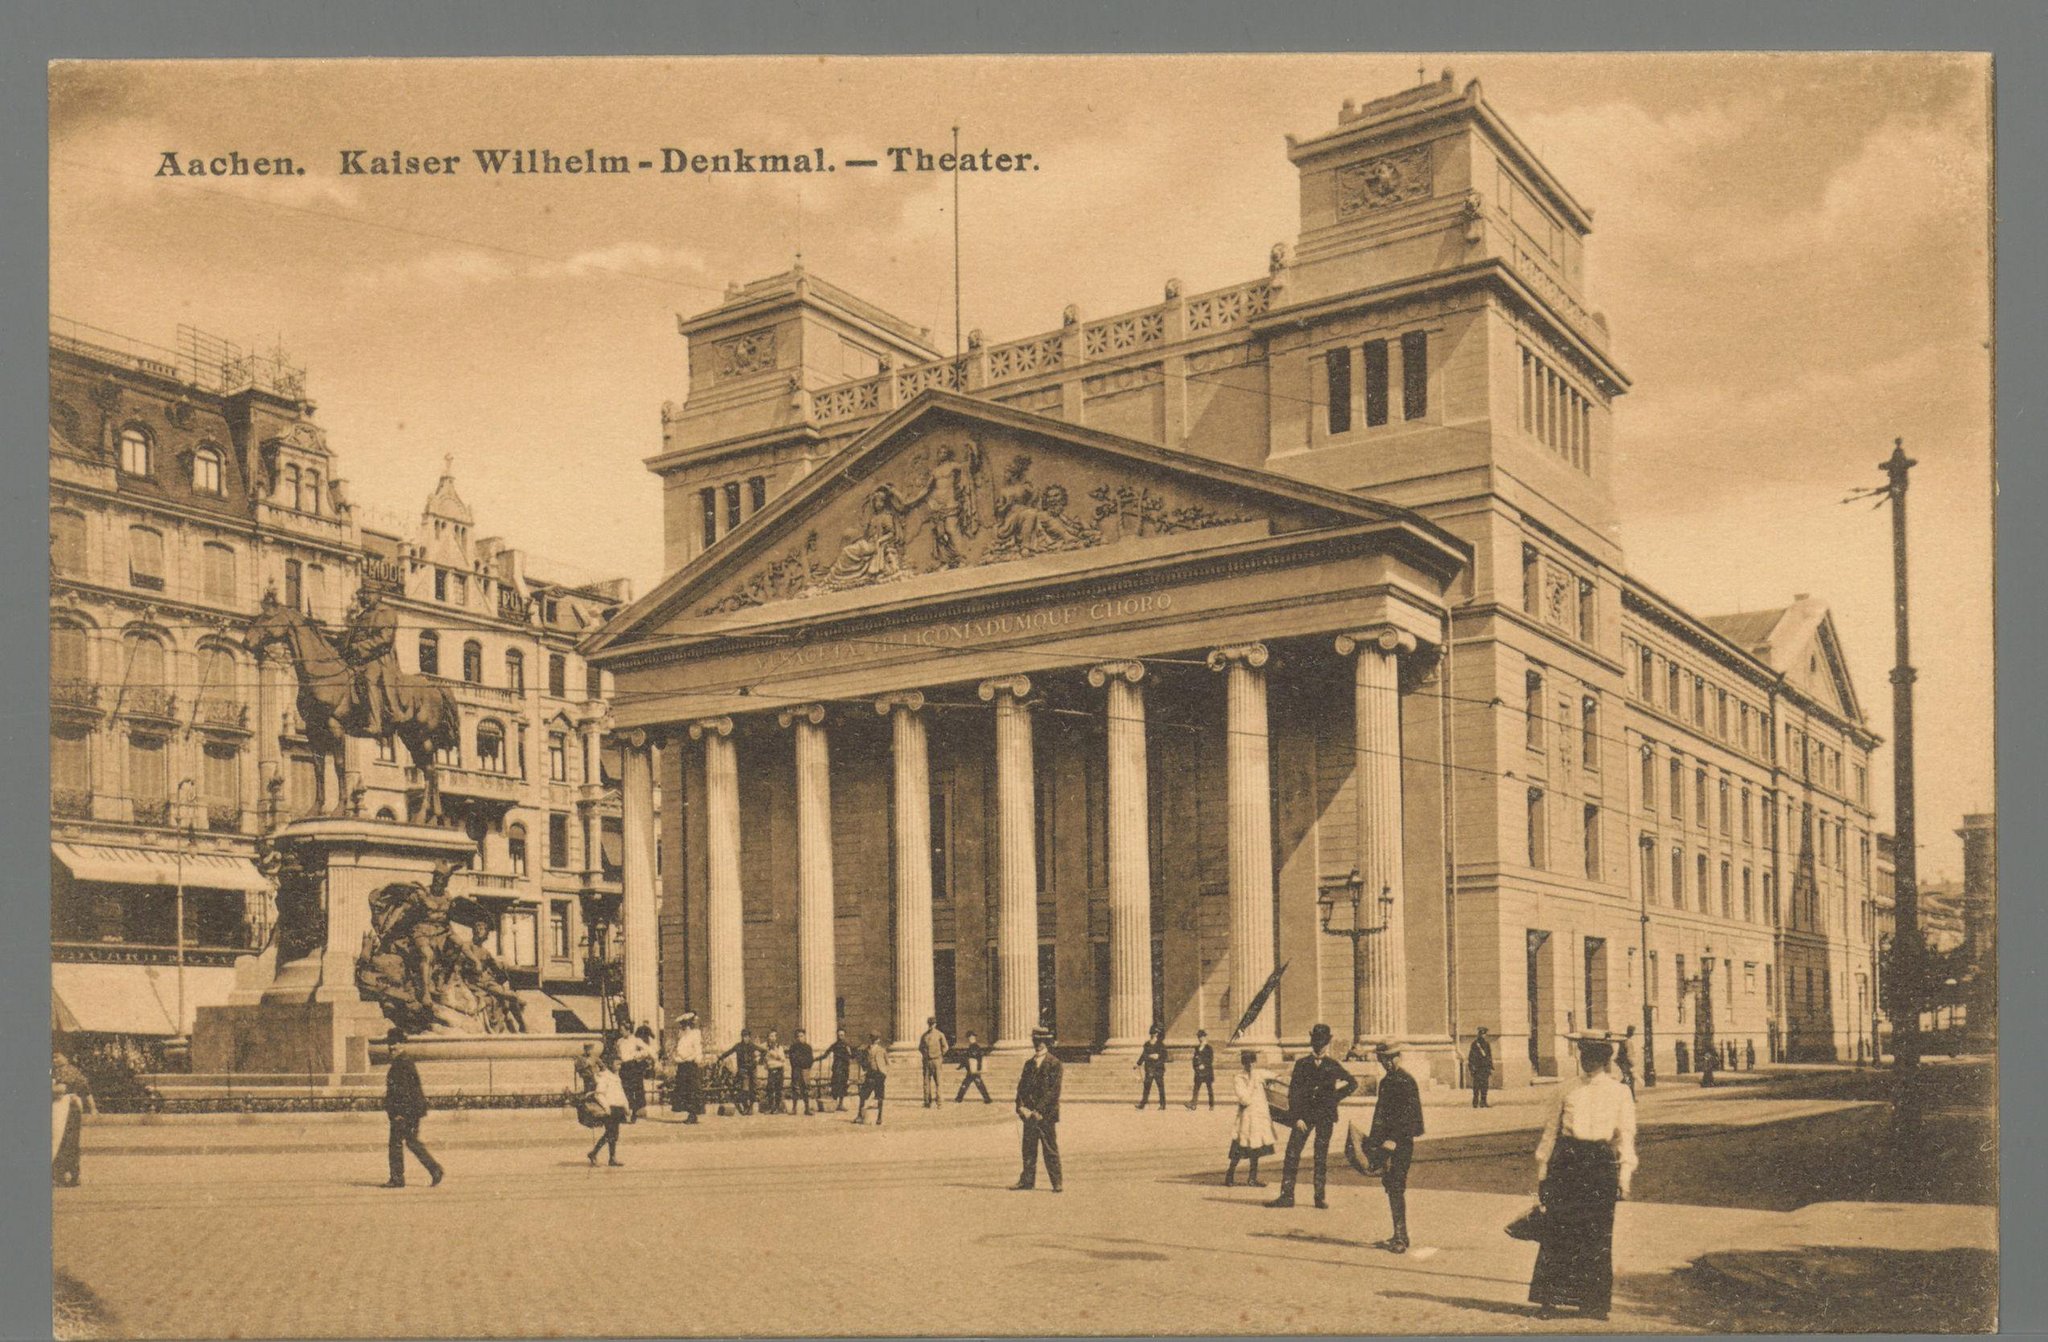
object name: photomechanical print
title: Aachen. Kaiser Wilhelm-Denkmal.-Theater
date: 1905-1910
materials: cardboard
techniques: photograph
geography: aachen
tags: berlin, wilhelm i (keizer van duitsland), theatre (building), monument, statue